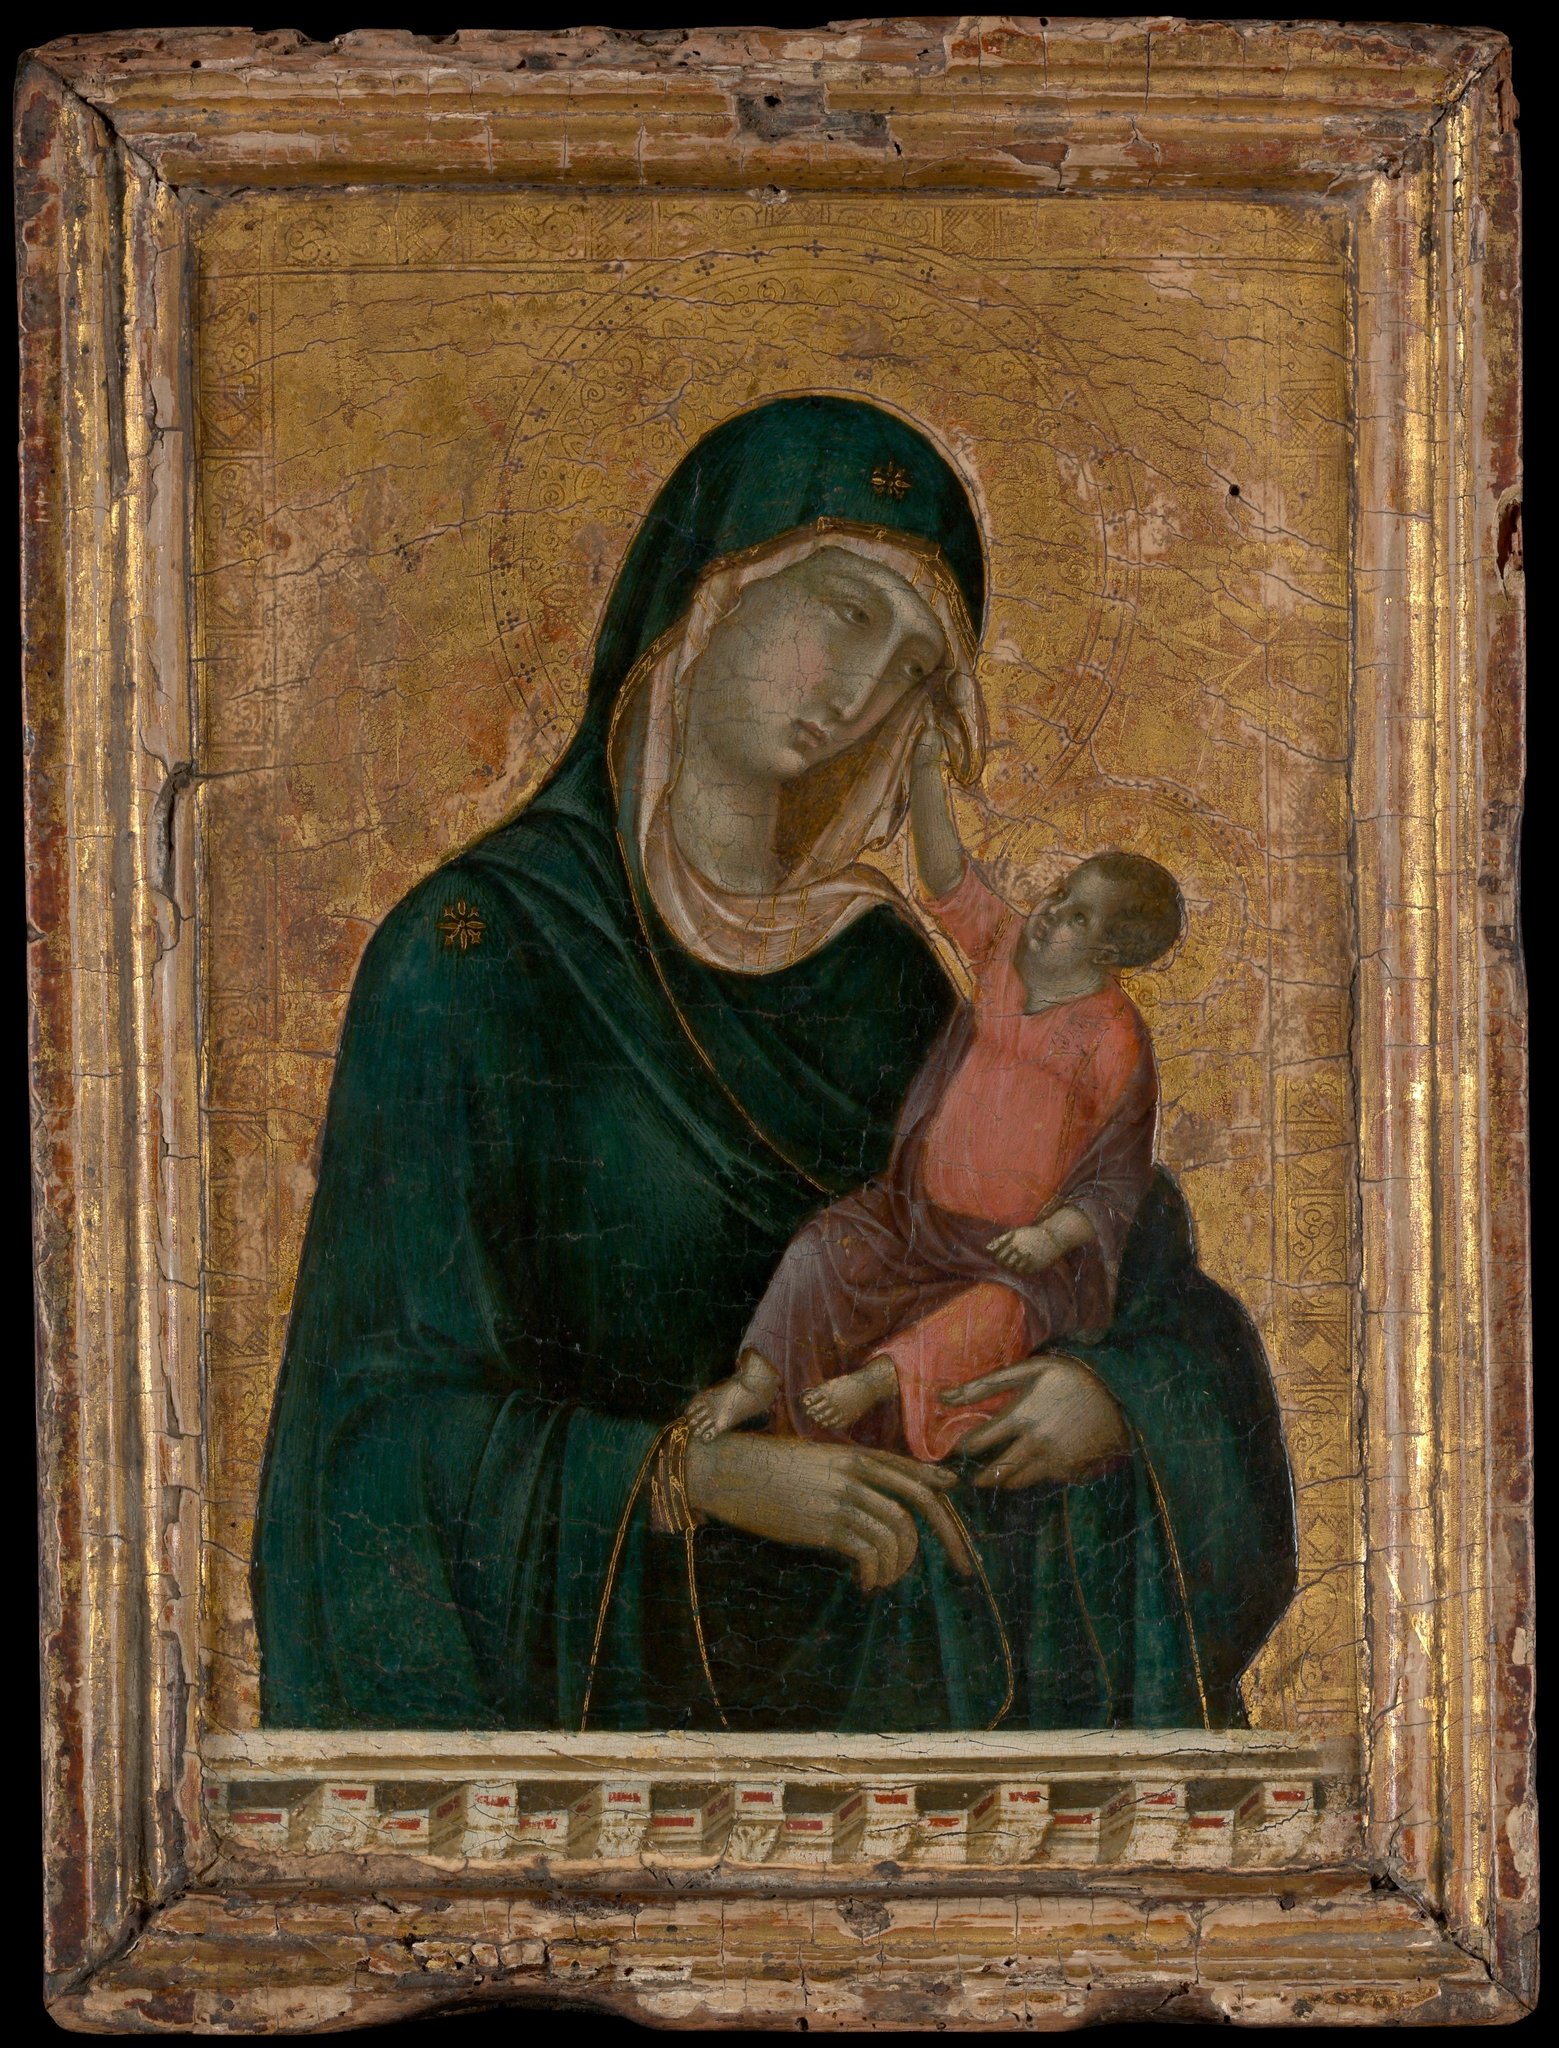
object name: painting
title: Madonna and Child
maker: duccio di buoninsegna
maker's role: artist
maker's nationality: italian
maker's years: 1278-1318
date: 1290-1300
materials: gold, paint, wood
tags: madonna and child